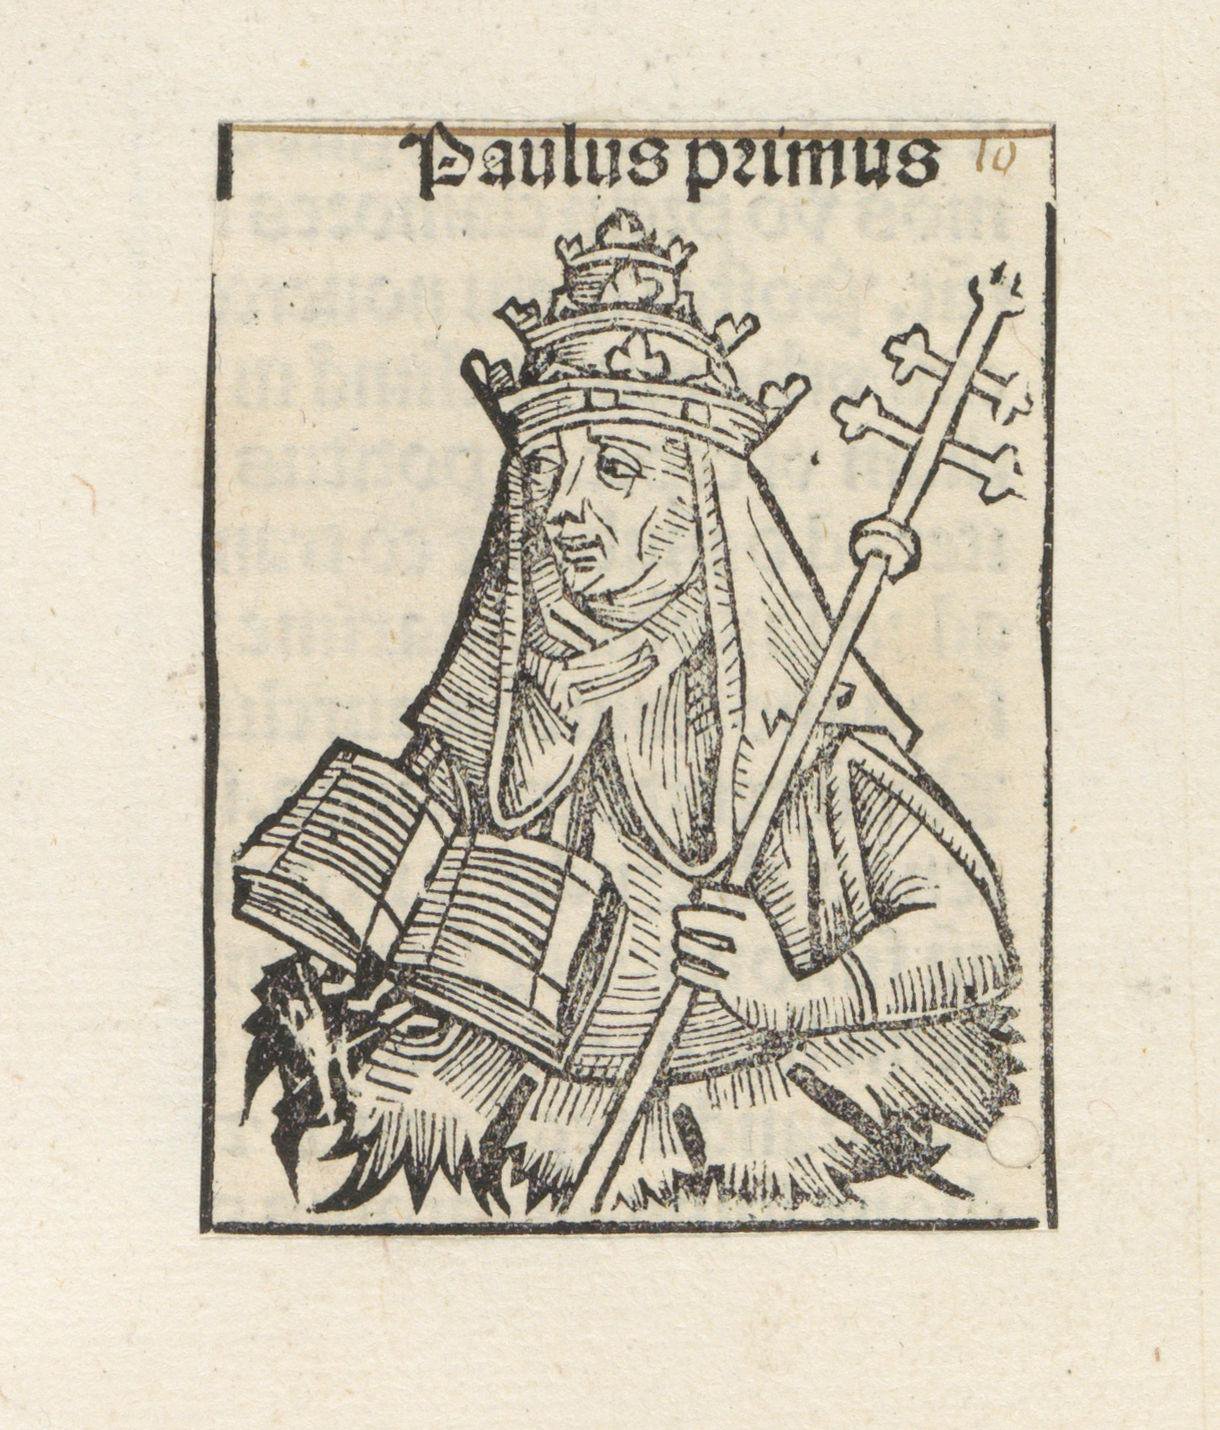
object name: print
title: Paus Paulus I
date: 1493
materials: paper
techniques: letterpress printing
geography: nuremberg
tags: pope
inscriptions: inscription: ‘10’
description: Een bloemkelk met een paus. Hij draagt een tiara en heeft een opengeslagen bijbel en staf met een dubbel kruis in zijn handen. De voorstelling is onderdeel van de opeenvolging pausen in de Liber Chronicarum. De tekst identificeert de man als paus Paulus I. De prent maakt deel uit van een album.